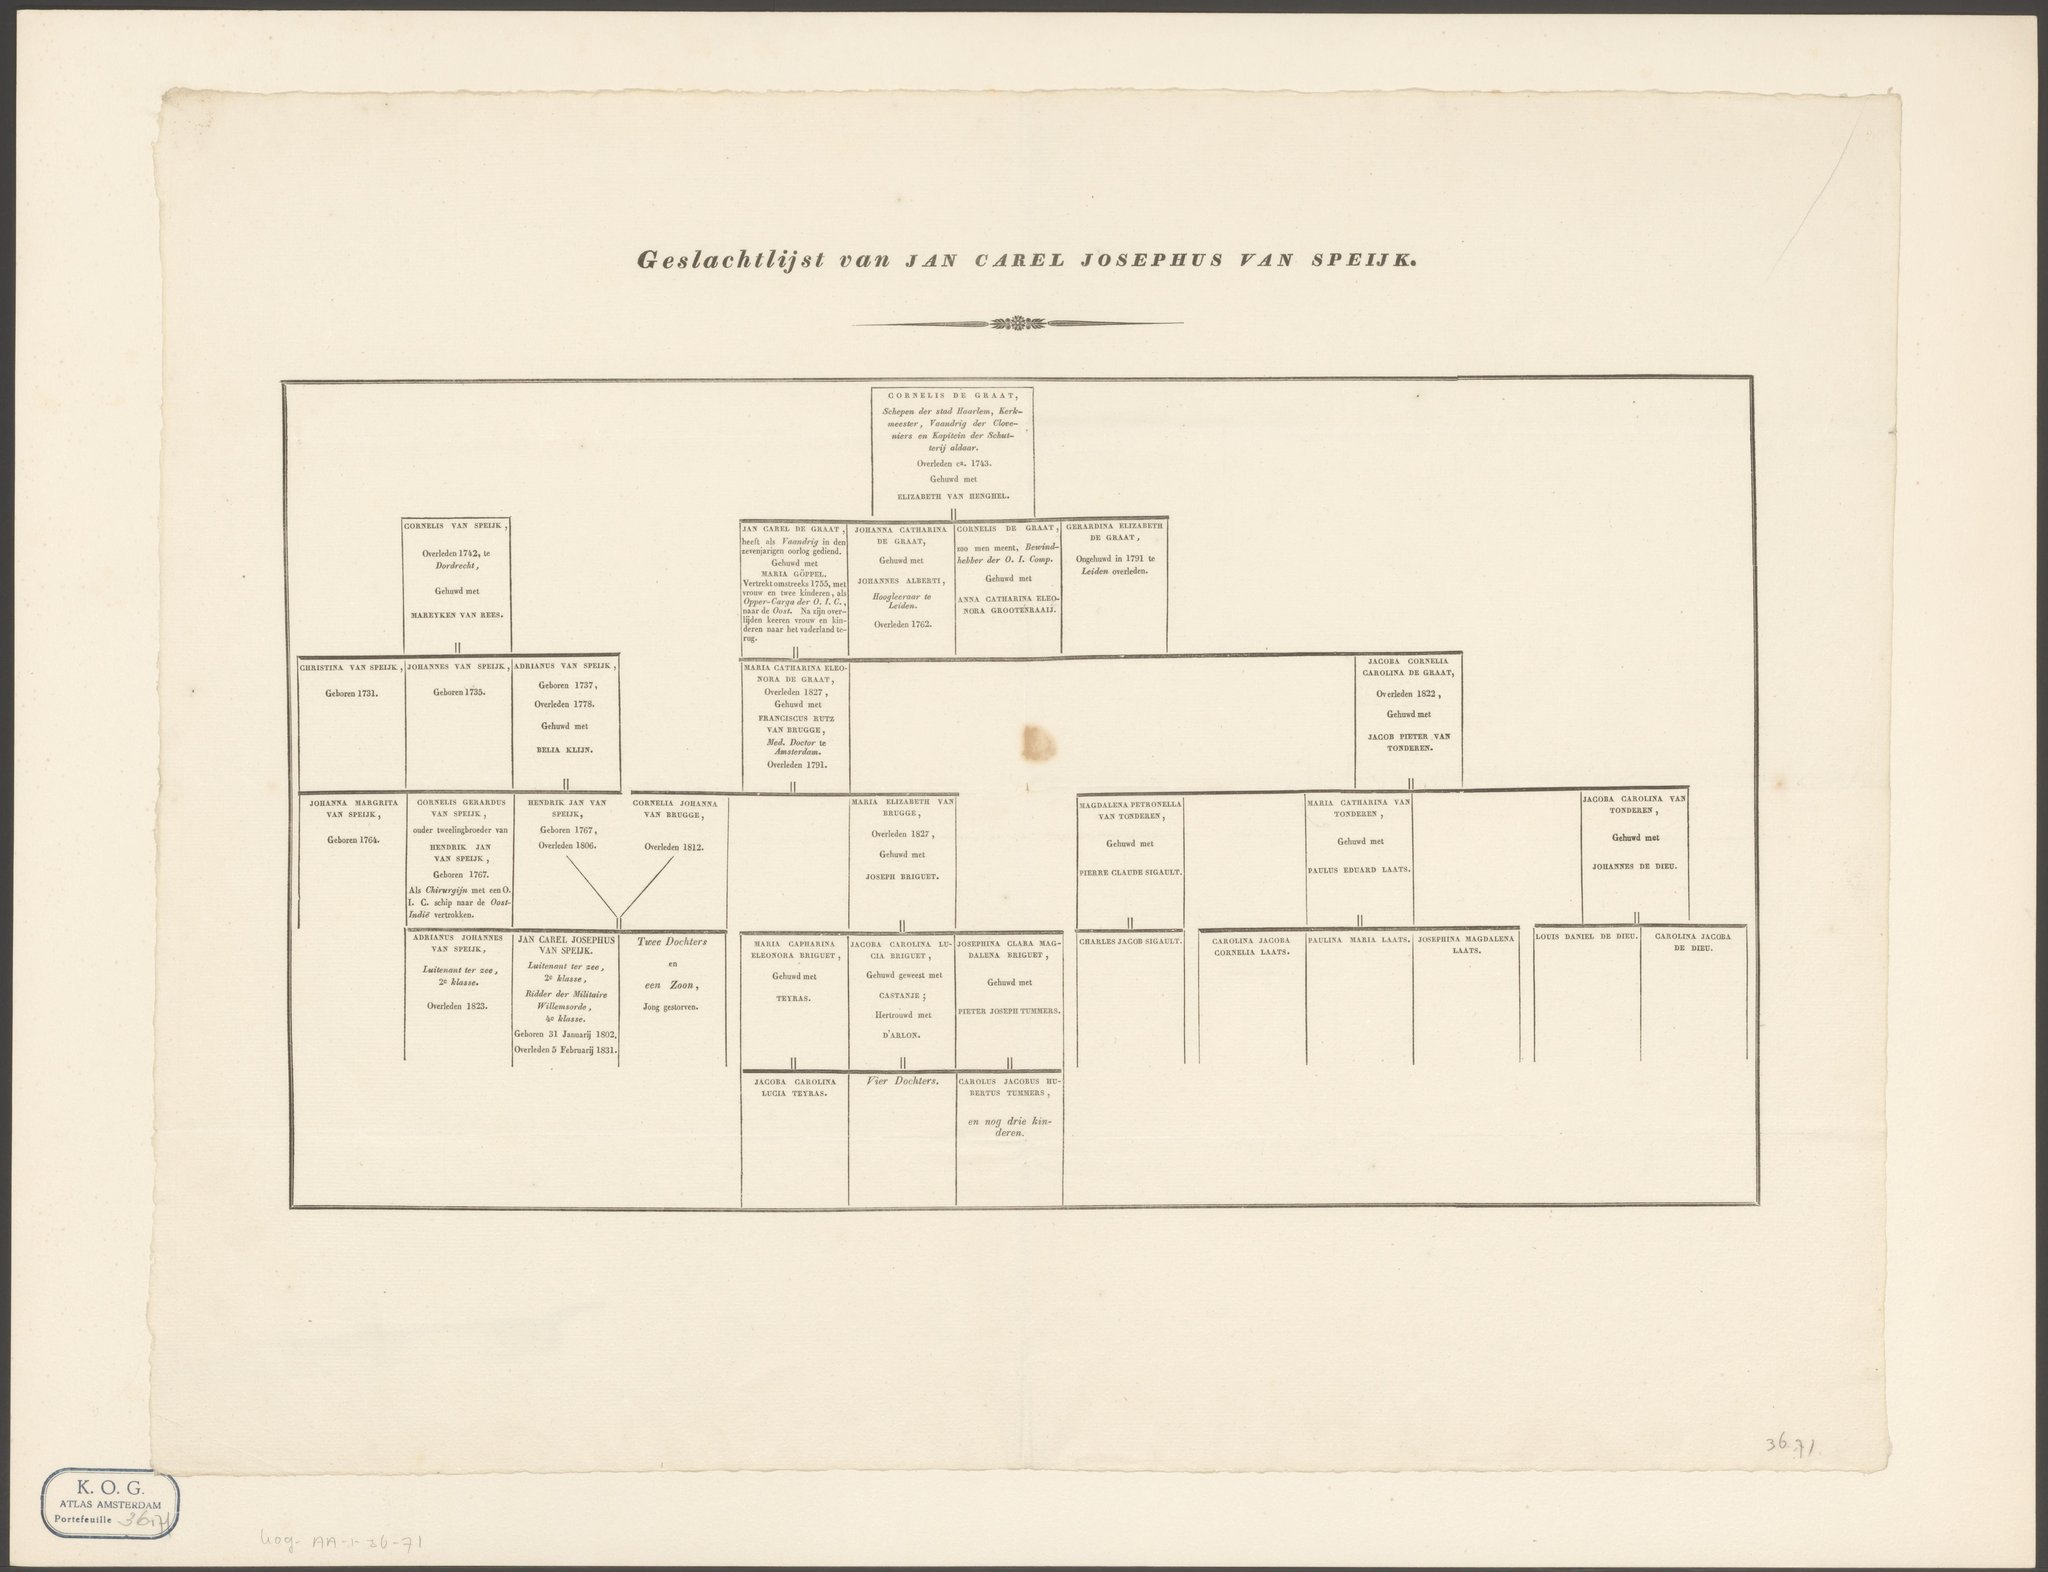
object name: text sheet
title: Geslachtslijst van Jan Carel Josephus van Speijk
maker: Anonymous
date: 1831-1899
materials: paper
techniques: letterpress printing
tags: amsterdam, antwerp, jan van speyk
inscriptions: collector's mark: Lugt 1641b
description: Onderwerpsrubriek binnen de Atlas Amsterdam: Armwezen en liefdadige instellingen: I. Stadsinrichtingen: Burgerweeshuis.